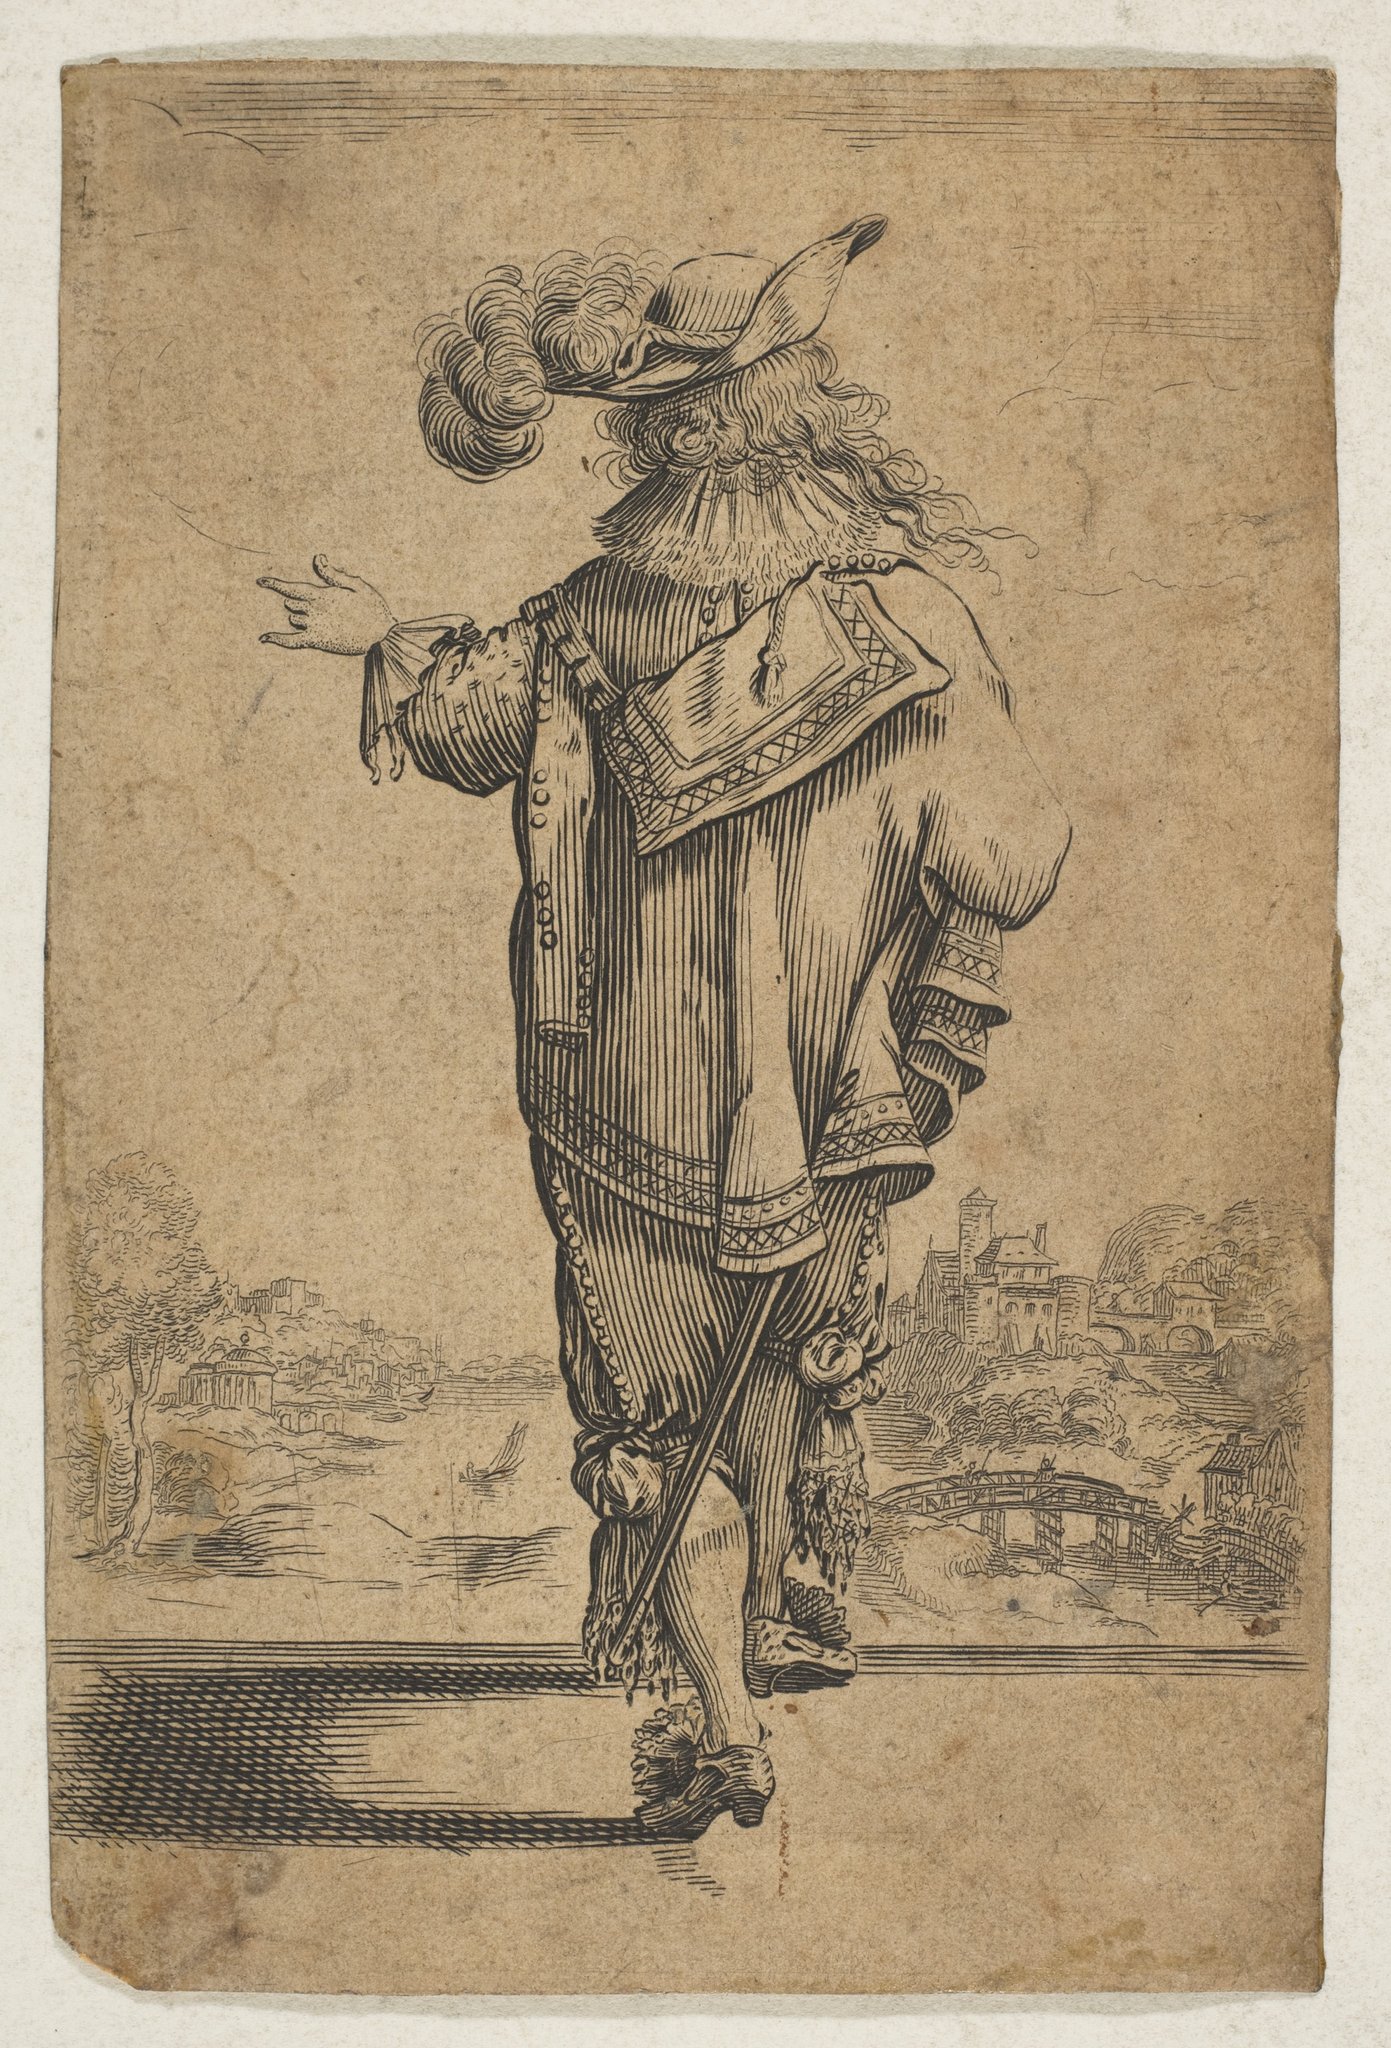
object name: print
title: Gentleman Seen from the Back Indicating a Landscape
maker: anonymous, french, 17th century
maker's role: artist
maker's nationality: french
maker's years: 1600-1700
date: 1629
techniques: etching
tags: men,landscapes